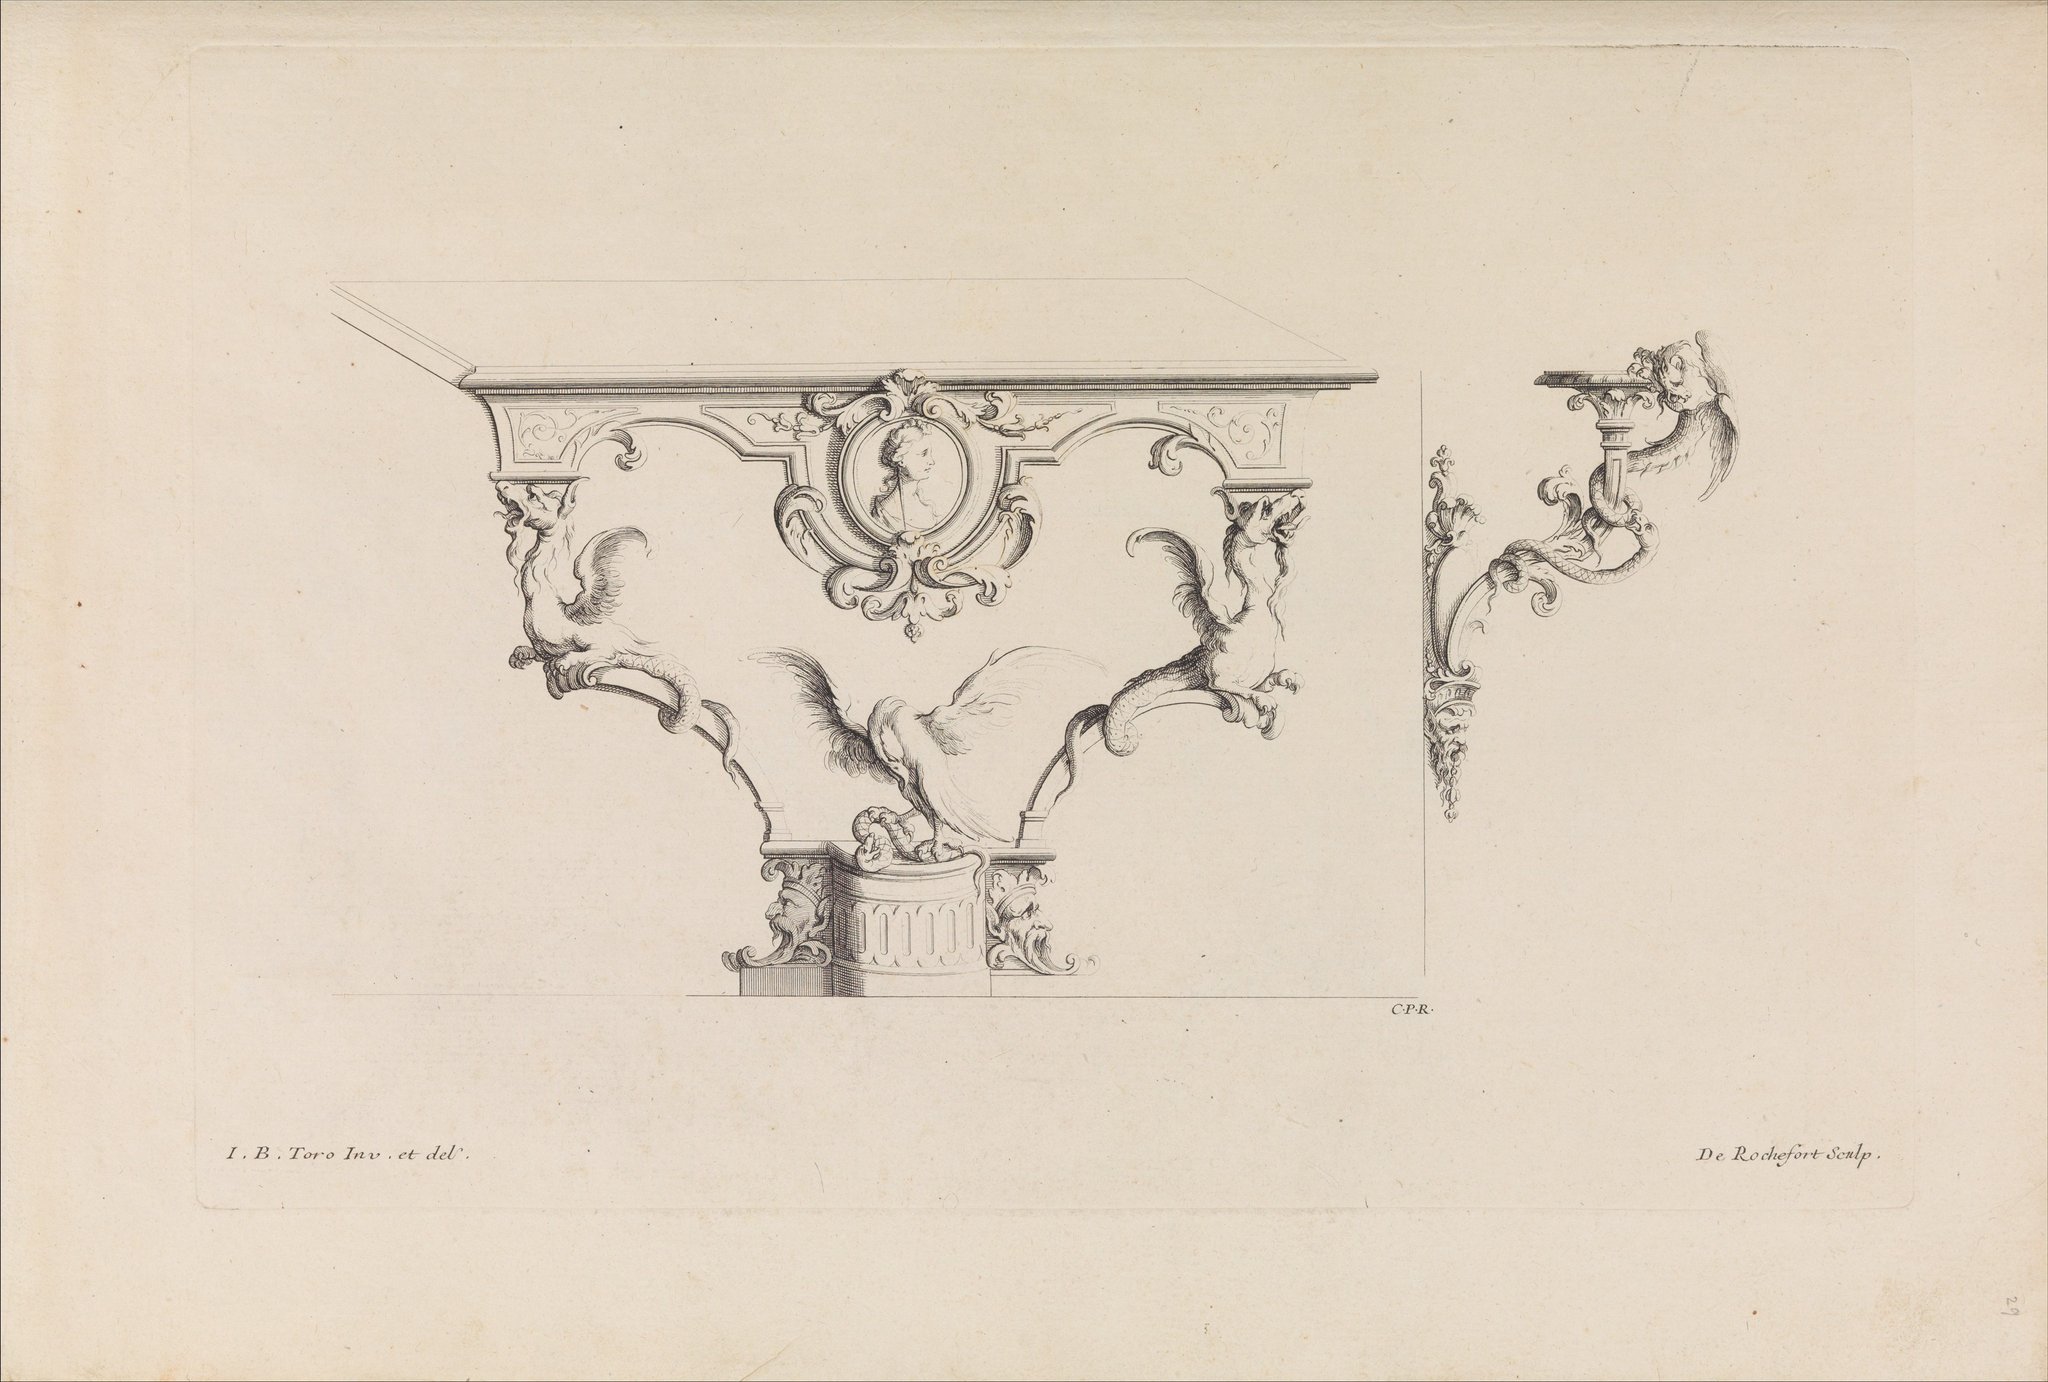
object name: album print ornament architecture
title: Livre de Tables de Diverses Formes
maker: jean bernard toro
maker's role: designer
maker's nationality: french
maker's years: 1672-1731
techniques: etching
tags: profiles,women,tables